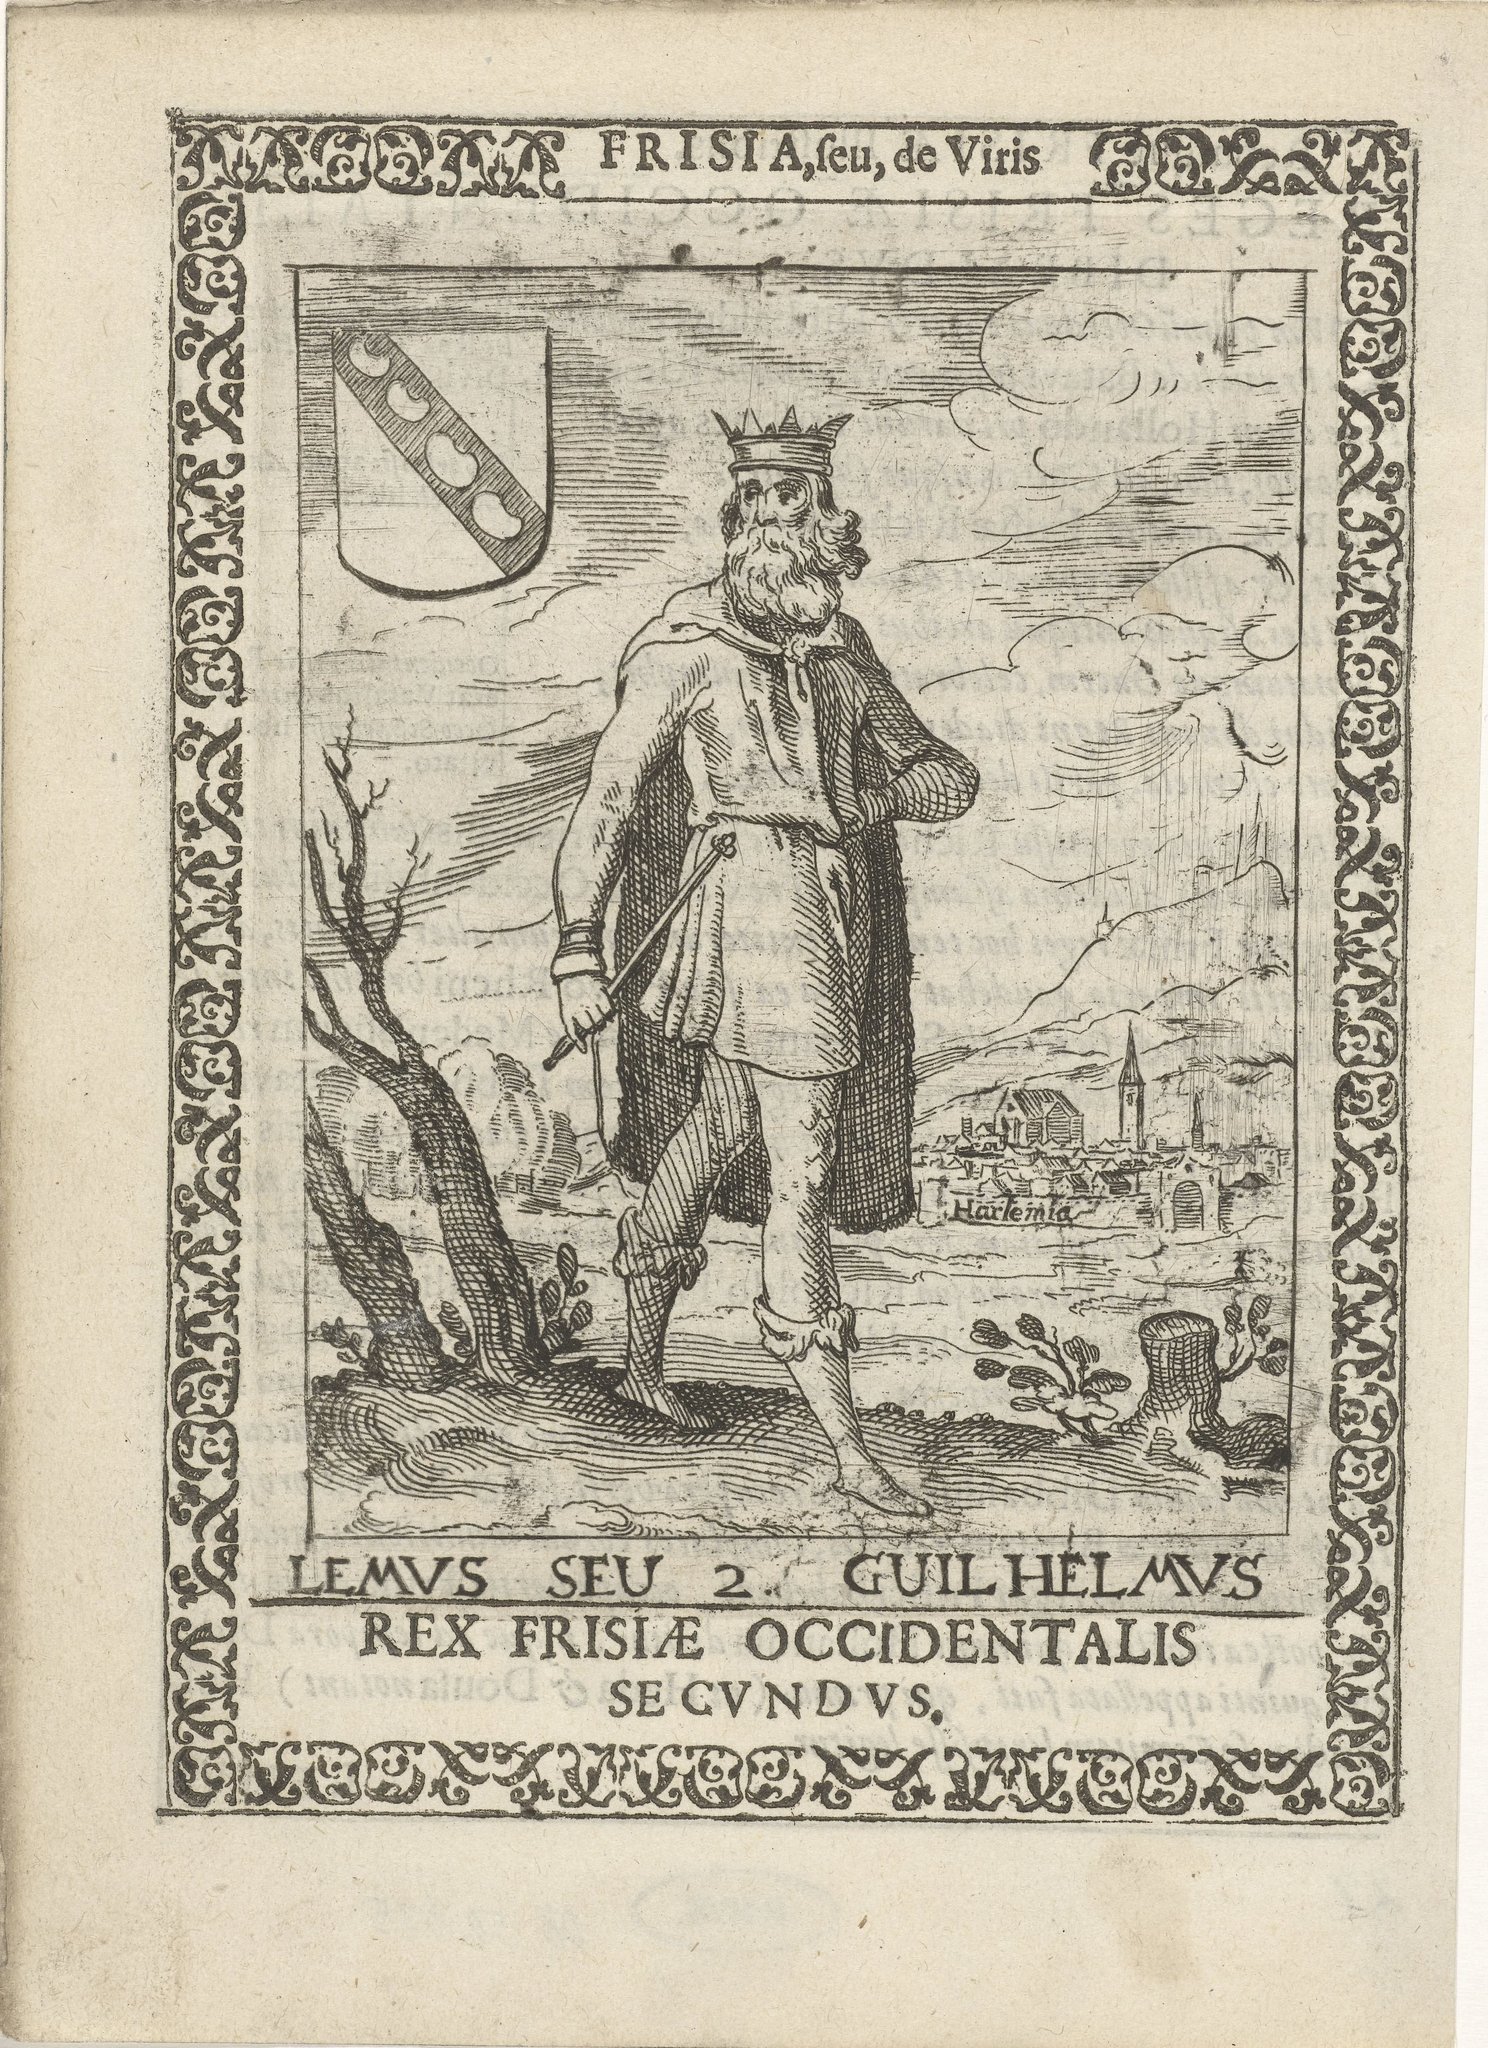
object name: print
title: Koningen en Potestaten van Friesland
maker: pieter feddes van harlingen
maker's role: painter, print maker, publisher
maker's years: 1586-1623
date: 1618-1620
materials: paper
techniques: etching, letterpress printing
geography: friesland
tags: ruler, sovereign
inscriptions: collector's mark: Lugt 2228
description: Willem II, tweede koning der West-Friezen. Staande ten voeten uit, scepter in de hand. Op de achtergrond Haarlem. In een ornamentale omlijsting. Illustratie, met tekst op achterzijde, afkomstig uit het boek: Frisia seu de viris rebusque Frisiae illustribus libri duo.